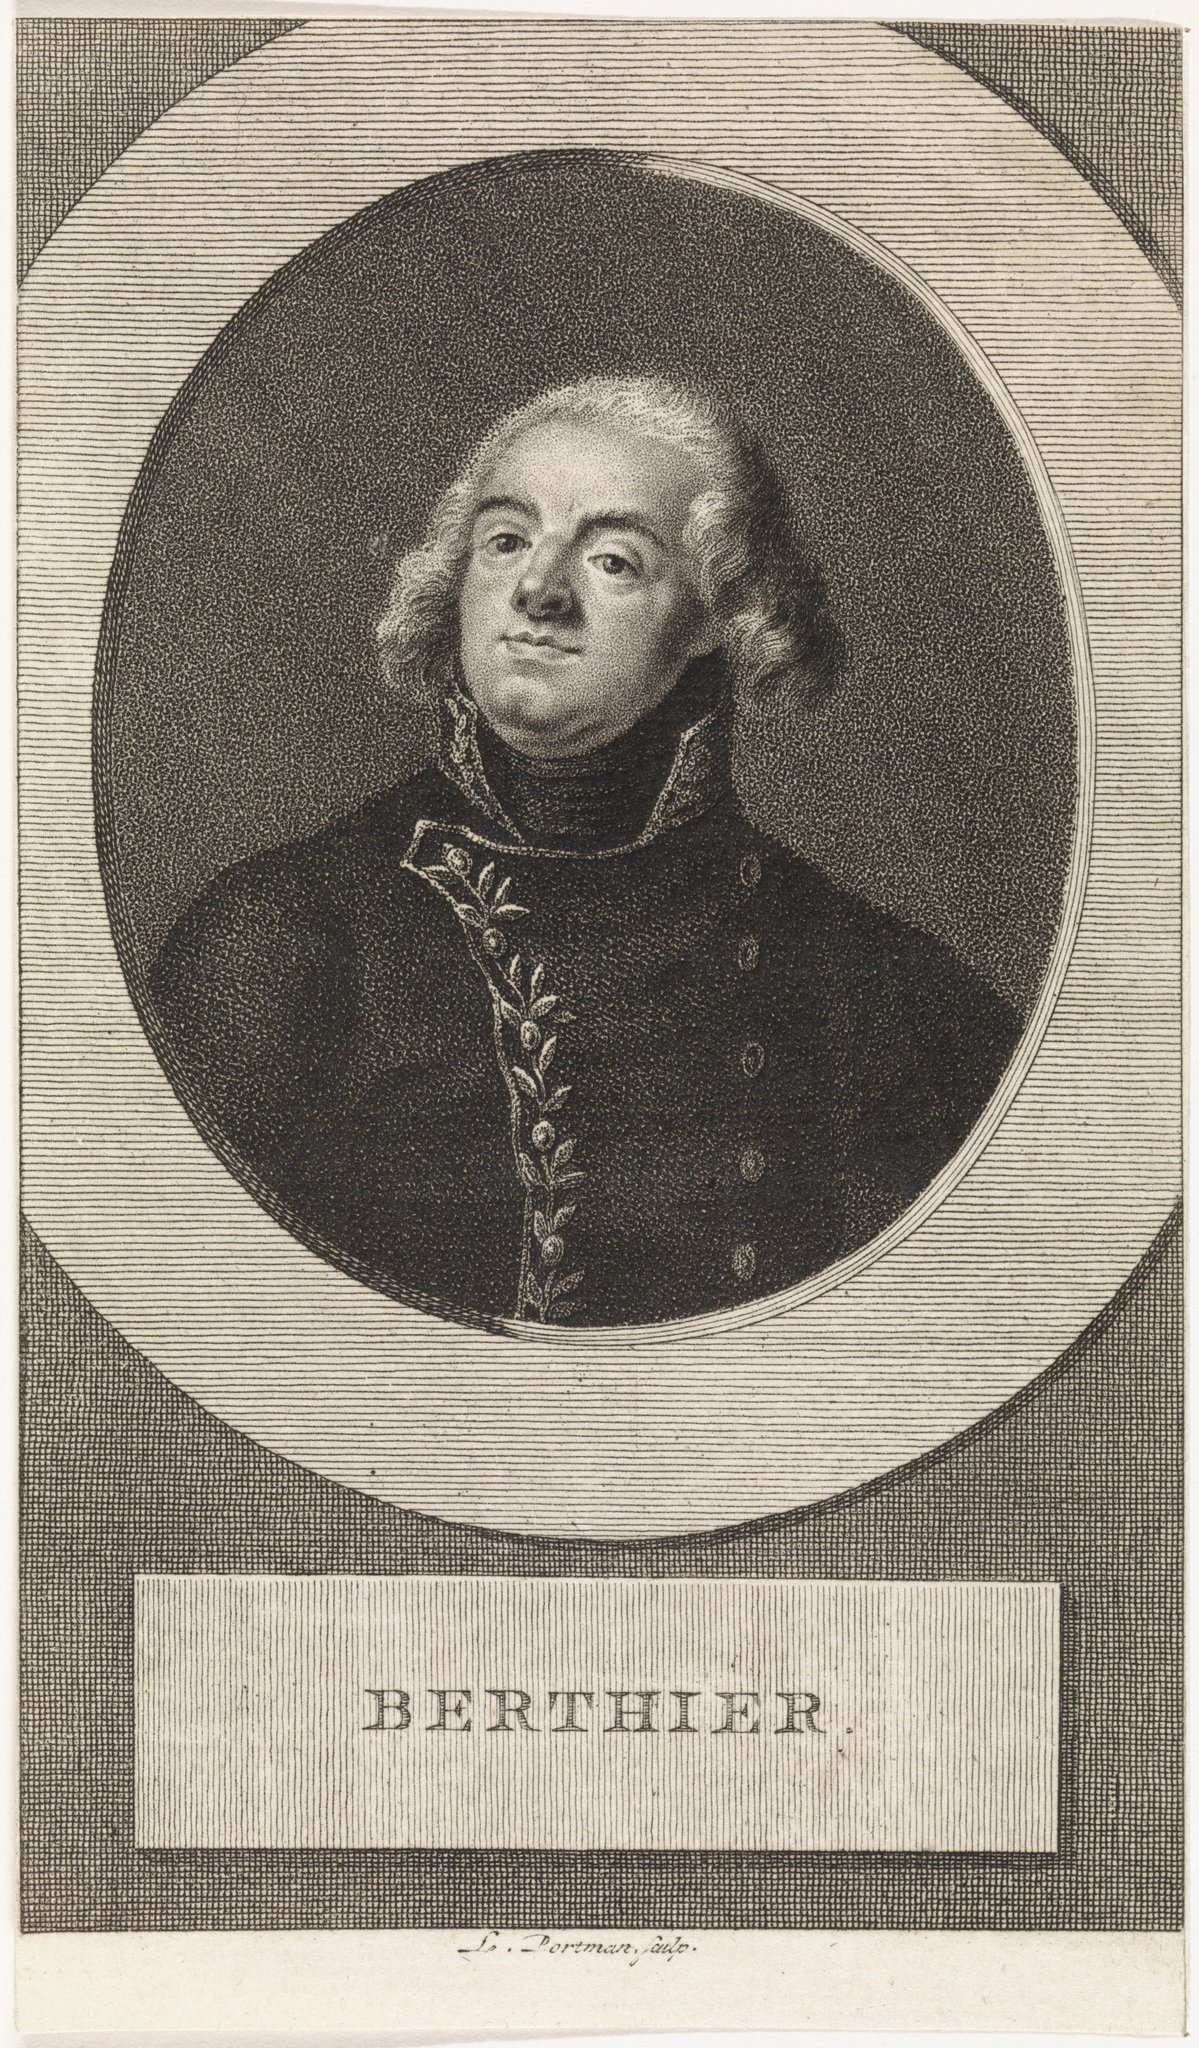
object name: print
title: Portret van Louis Alexandre Berthier, maarschalk van Frankrijk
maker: ludwig gottlieb portman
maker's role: print maker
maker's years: 1772-1828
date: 1806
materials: paper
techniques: stippled etching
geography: amsterdam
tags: versailles, bamberg, militair, louis-alexandre berthier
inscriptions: collector's mark: Lugt 2228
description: Prent ook gebruikt als illustratie in: Tafereelen van de staatsomwenteling in Frankrijk, deel 22, p. 220. Amsterdam: Johannes Allart, 1806.